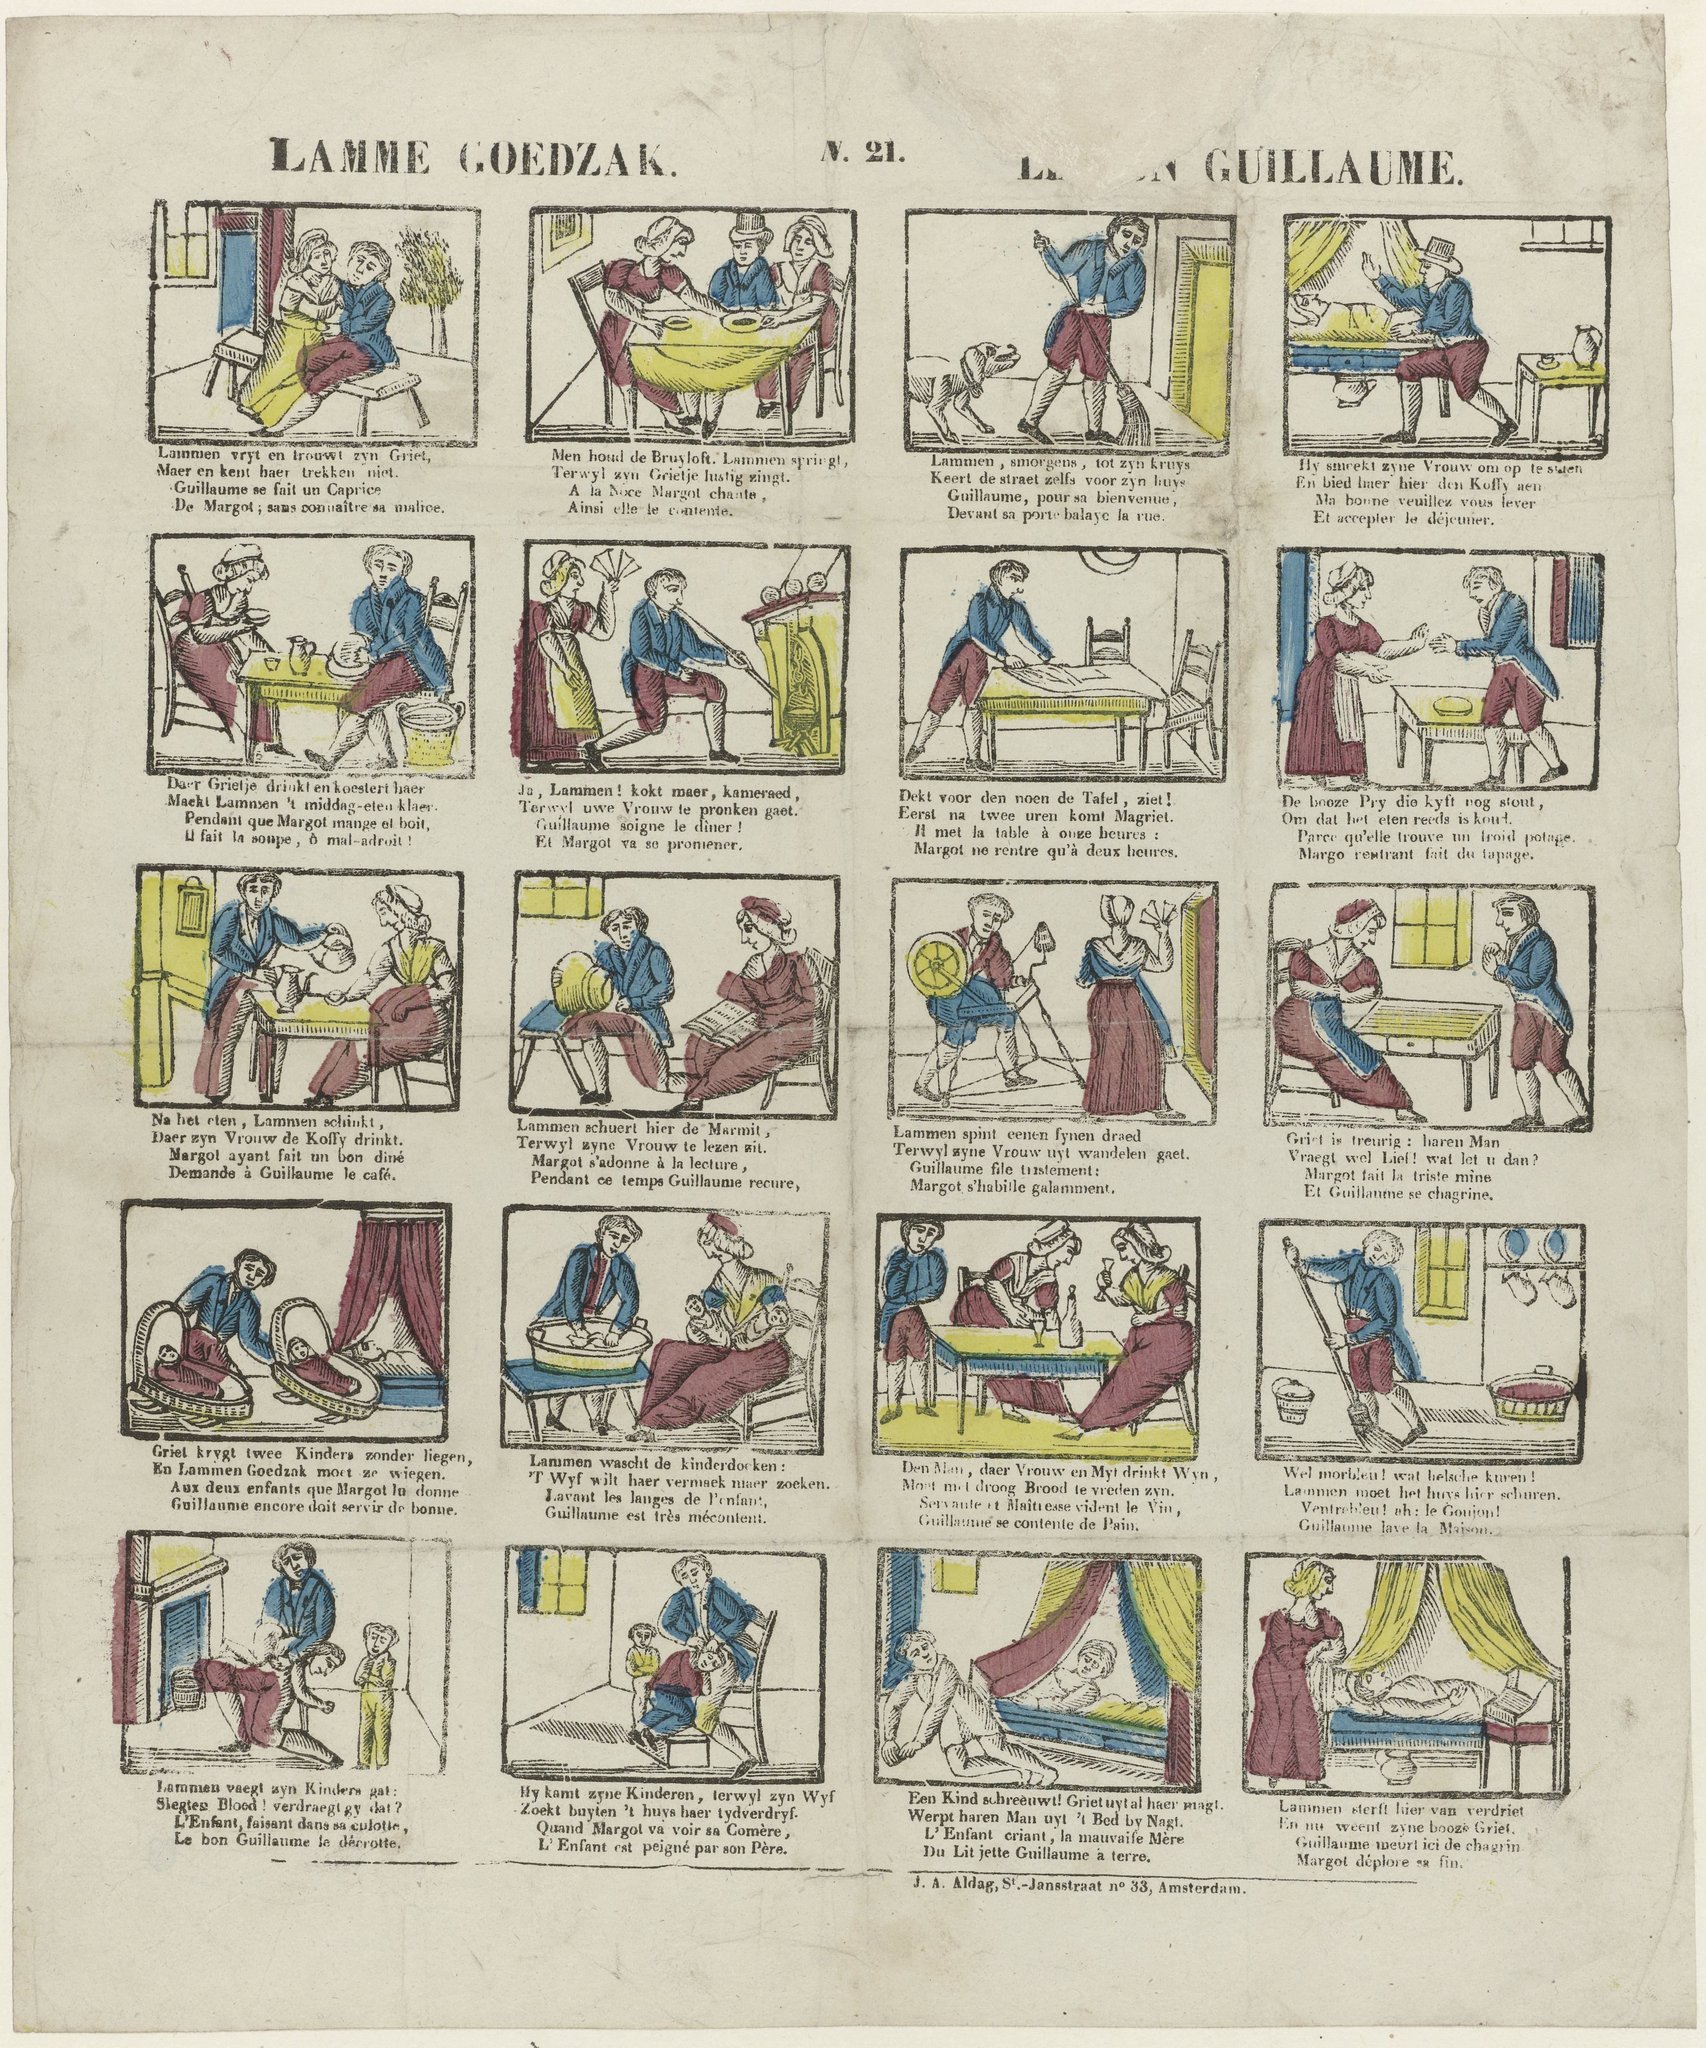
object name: popular print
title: Lamme goedzak / Le bon Guillaume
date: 1833-1856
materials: paper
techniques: colour, letterpress printing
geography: turnhout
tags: hen-pecked husband, 'betty', 'molly' (man who engages in women's work)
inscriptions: collector's mark: Lugt 2760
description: Blad met 20 voorstellingen over het leven en bezigheden van Lamme Goedzak en zijn Griet. Onder elke afbeelding een tweeregelig vers in het Nederlands en in het Frans. Genummerd midden boven: N. 21.